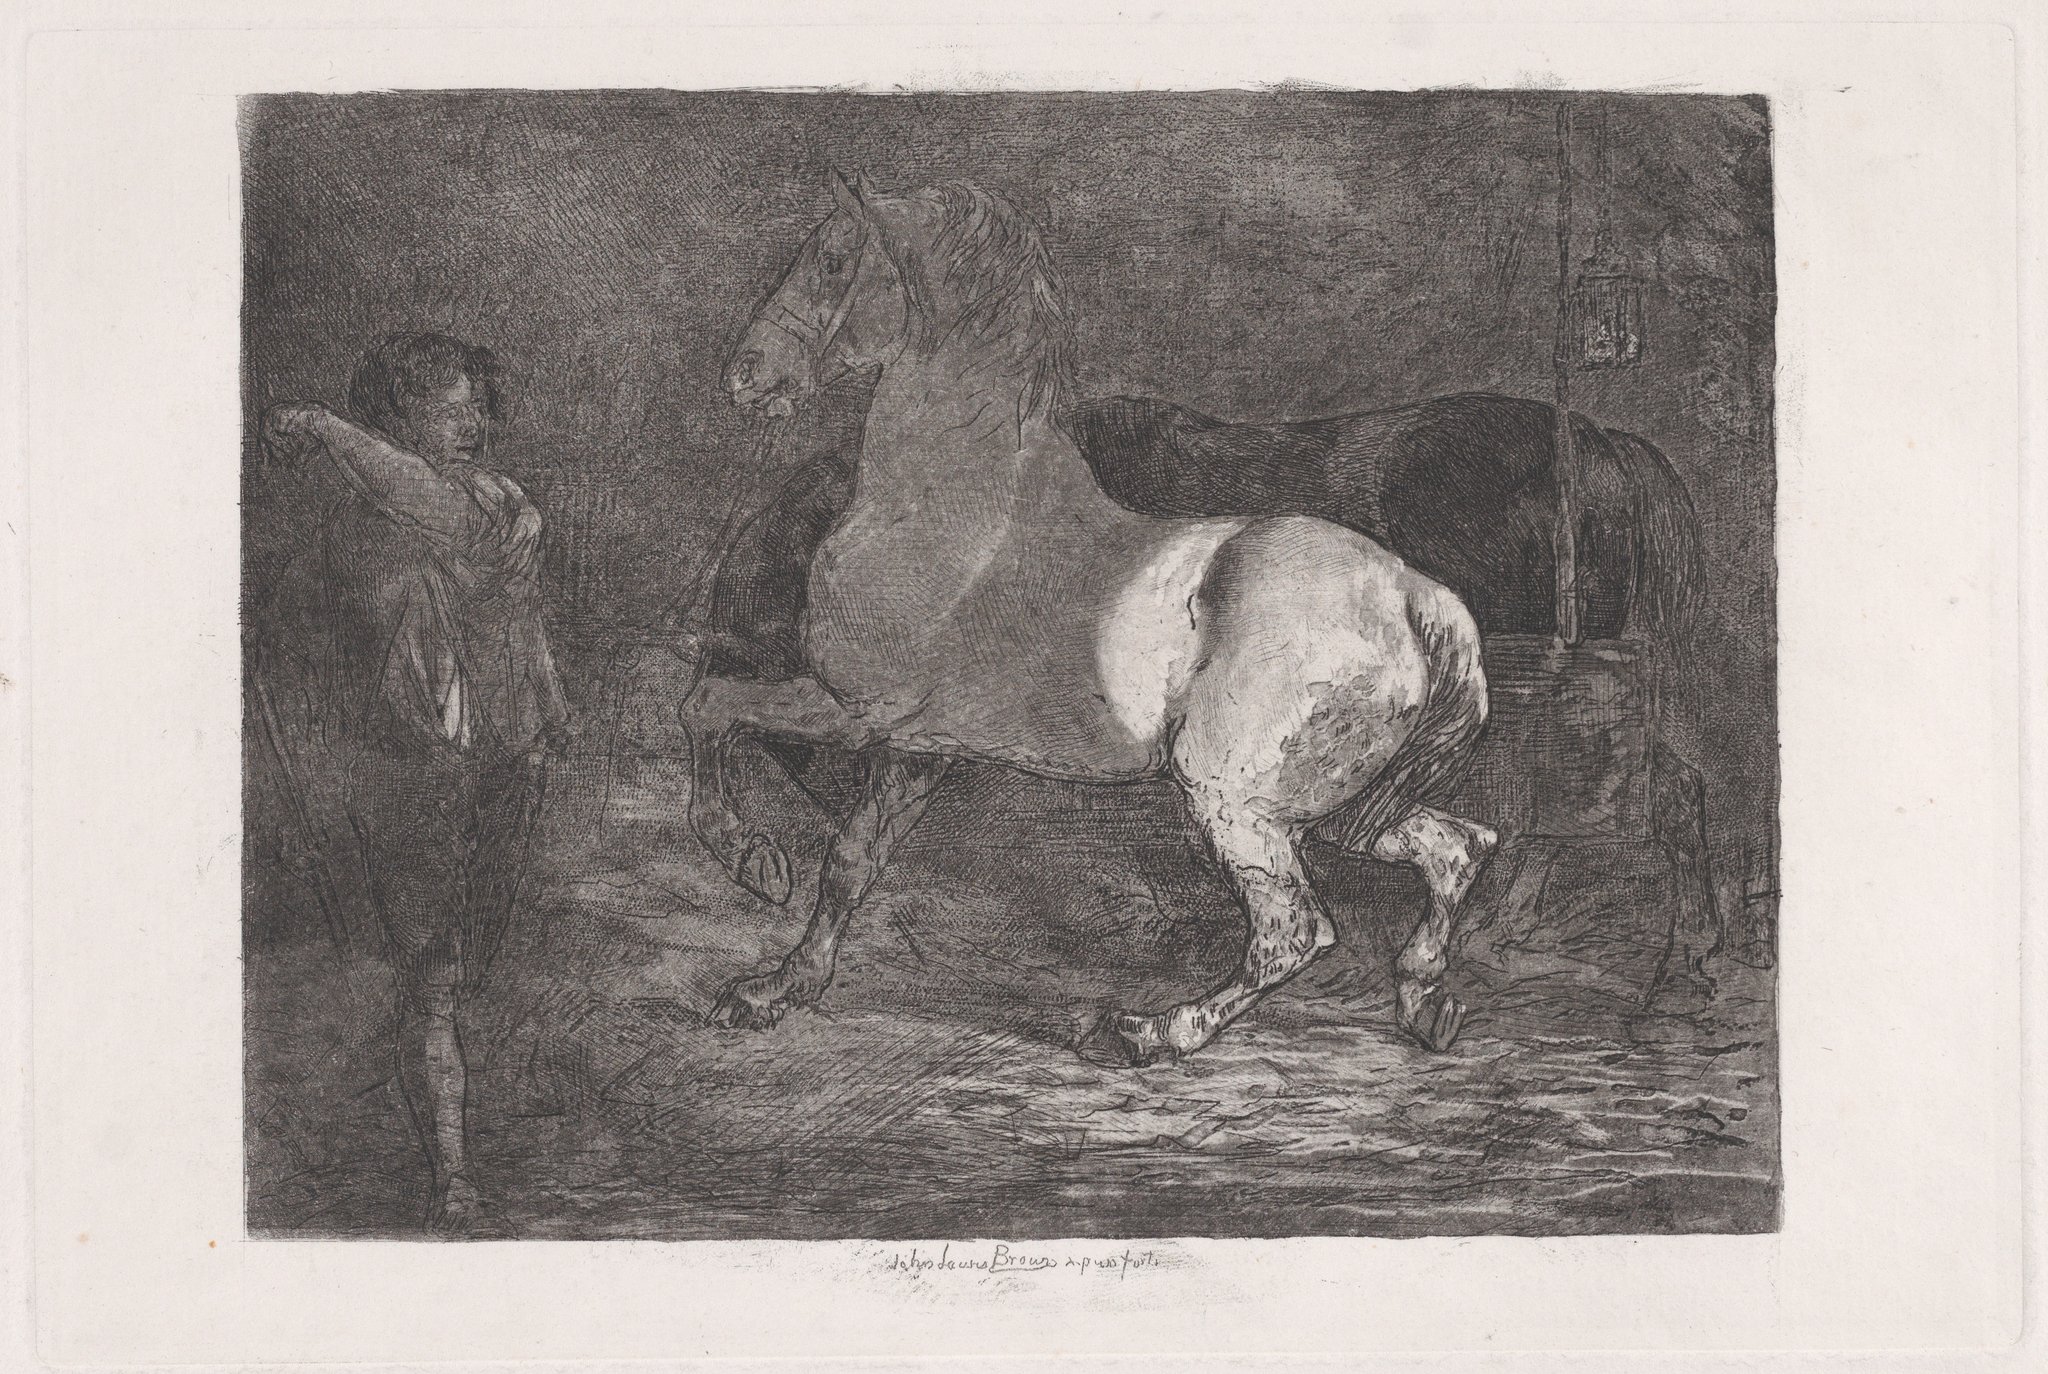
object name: print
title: L'Écurie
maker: john-lewis brown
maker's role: artist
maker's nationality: french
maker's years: 1829-1890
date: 1801-1900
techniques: etching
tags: horses